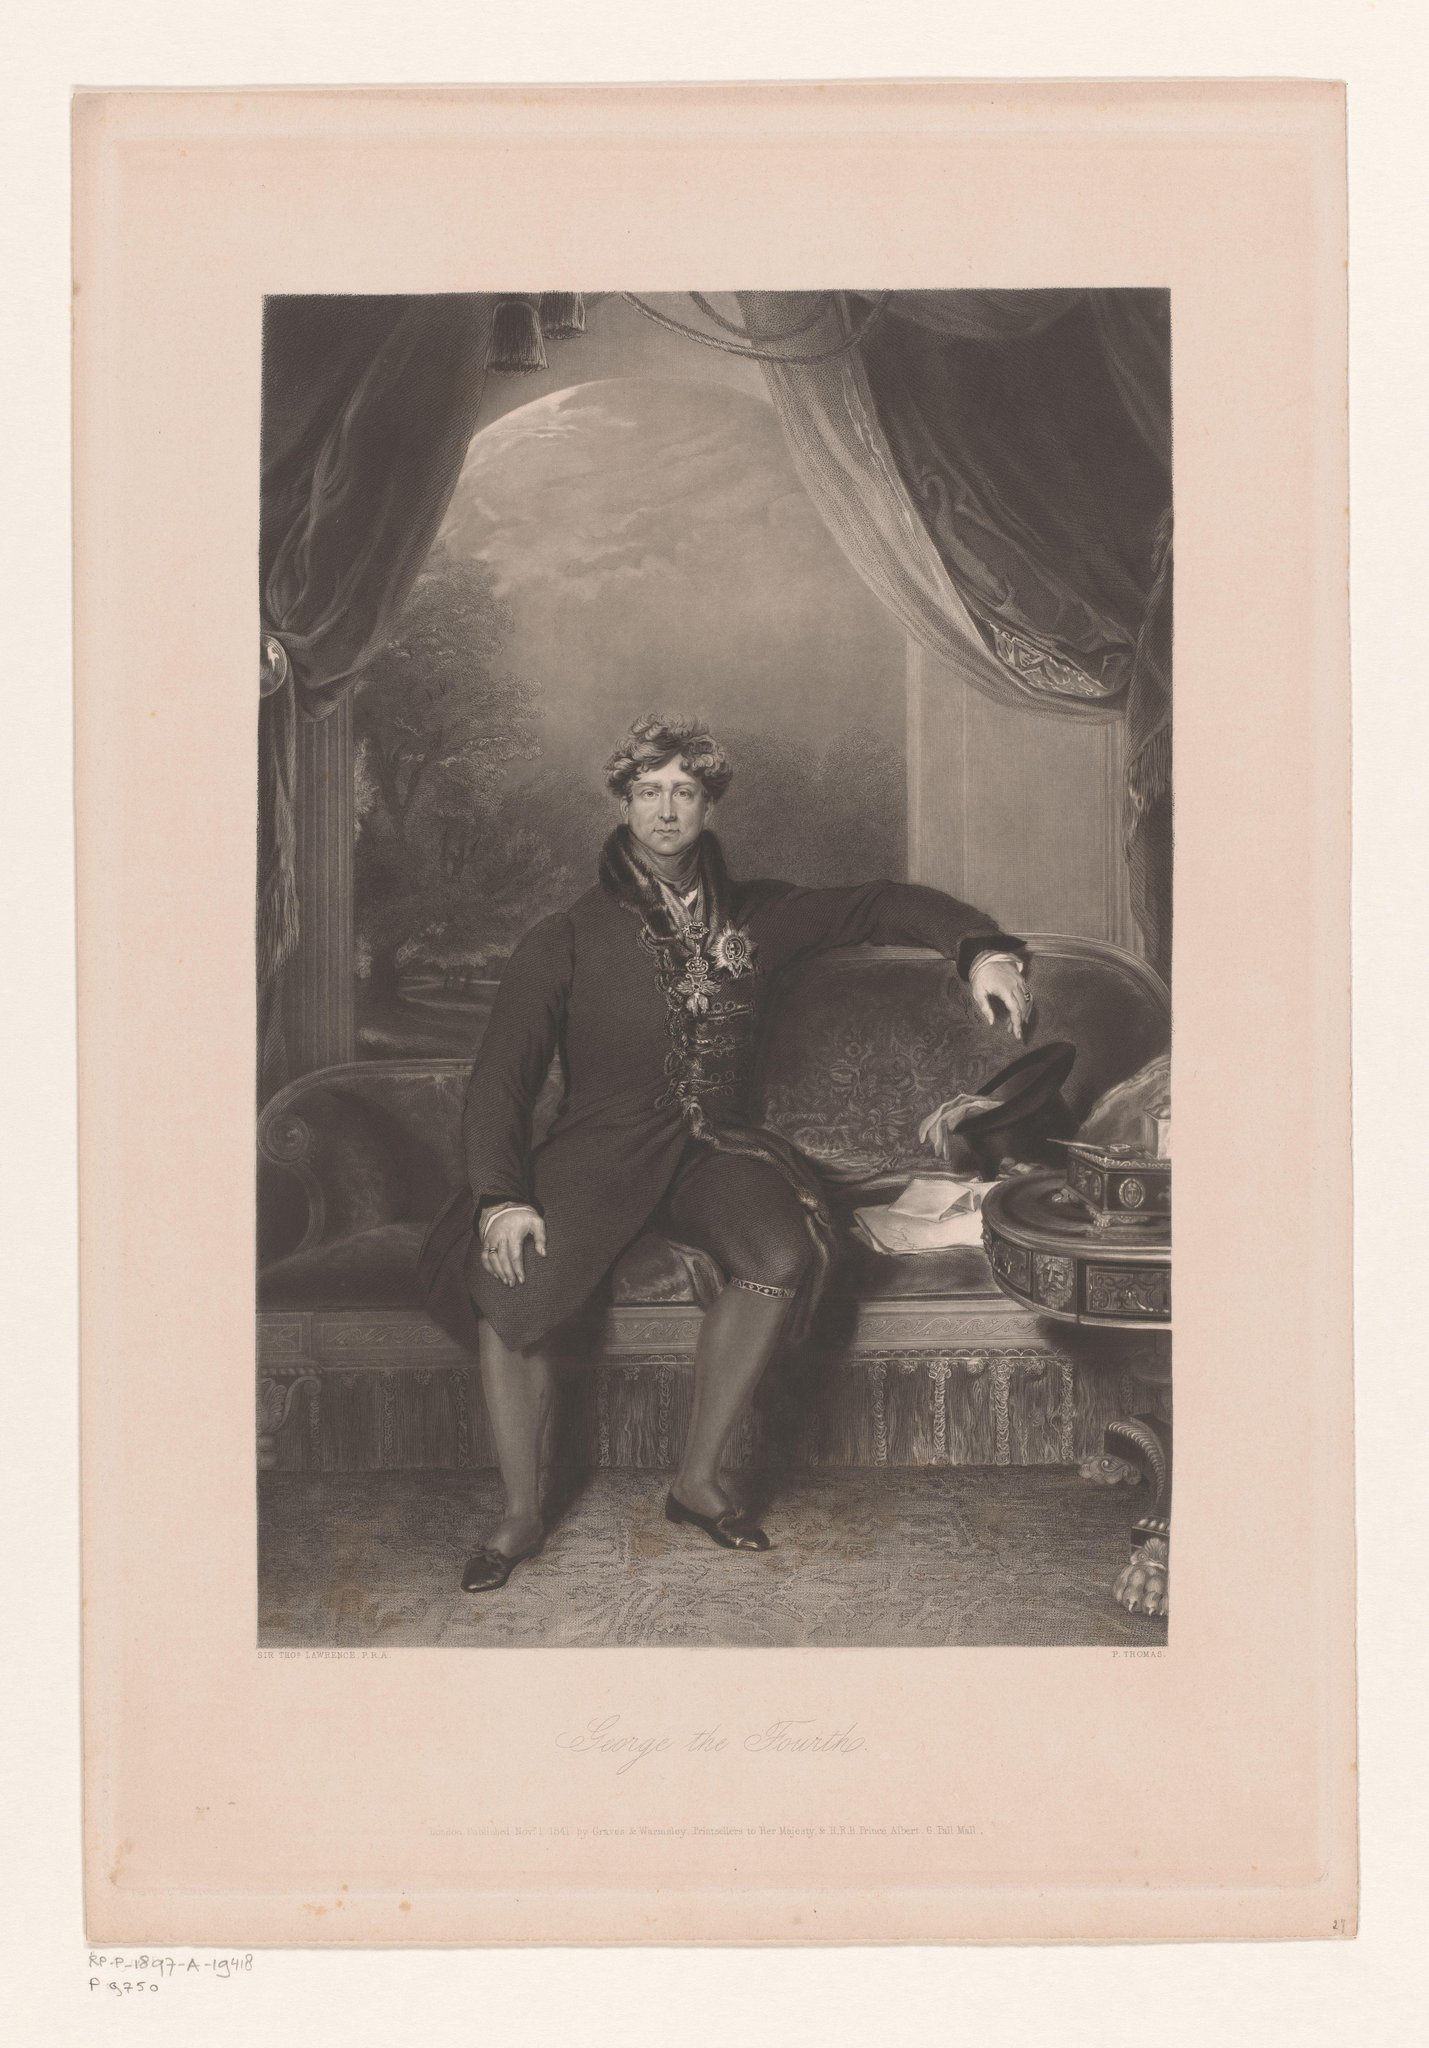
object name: print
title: Portrait of George IV, King of England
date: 1841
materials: paper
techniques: etching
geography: london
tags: george iv (koning van het verenigd koninkrijk), historical persons, king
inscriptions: collector's mark: Lugt 2228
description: George was prince regent from 1811 and king of England from 1820 until his death in 1830. He had himself portrayed by Lawrence a number of times. The ruler was anything but an easy sitter: he suffered from obesity as a result of his excessive lifestyle. Lawrence thus had to steer a course between credibility and fawning. His critics felt that he flattered the king too much.